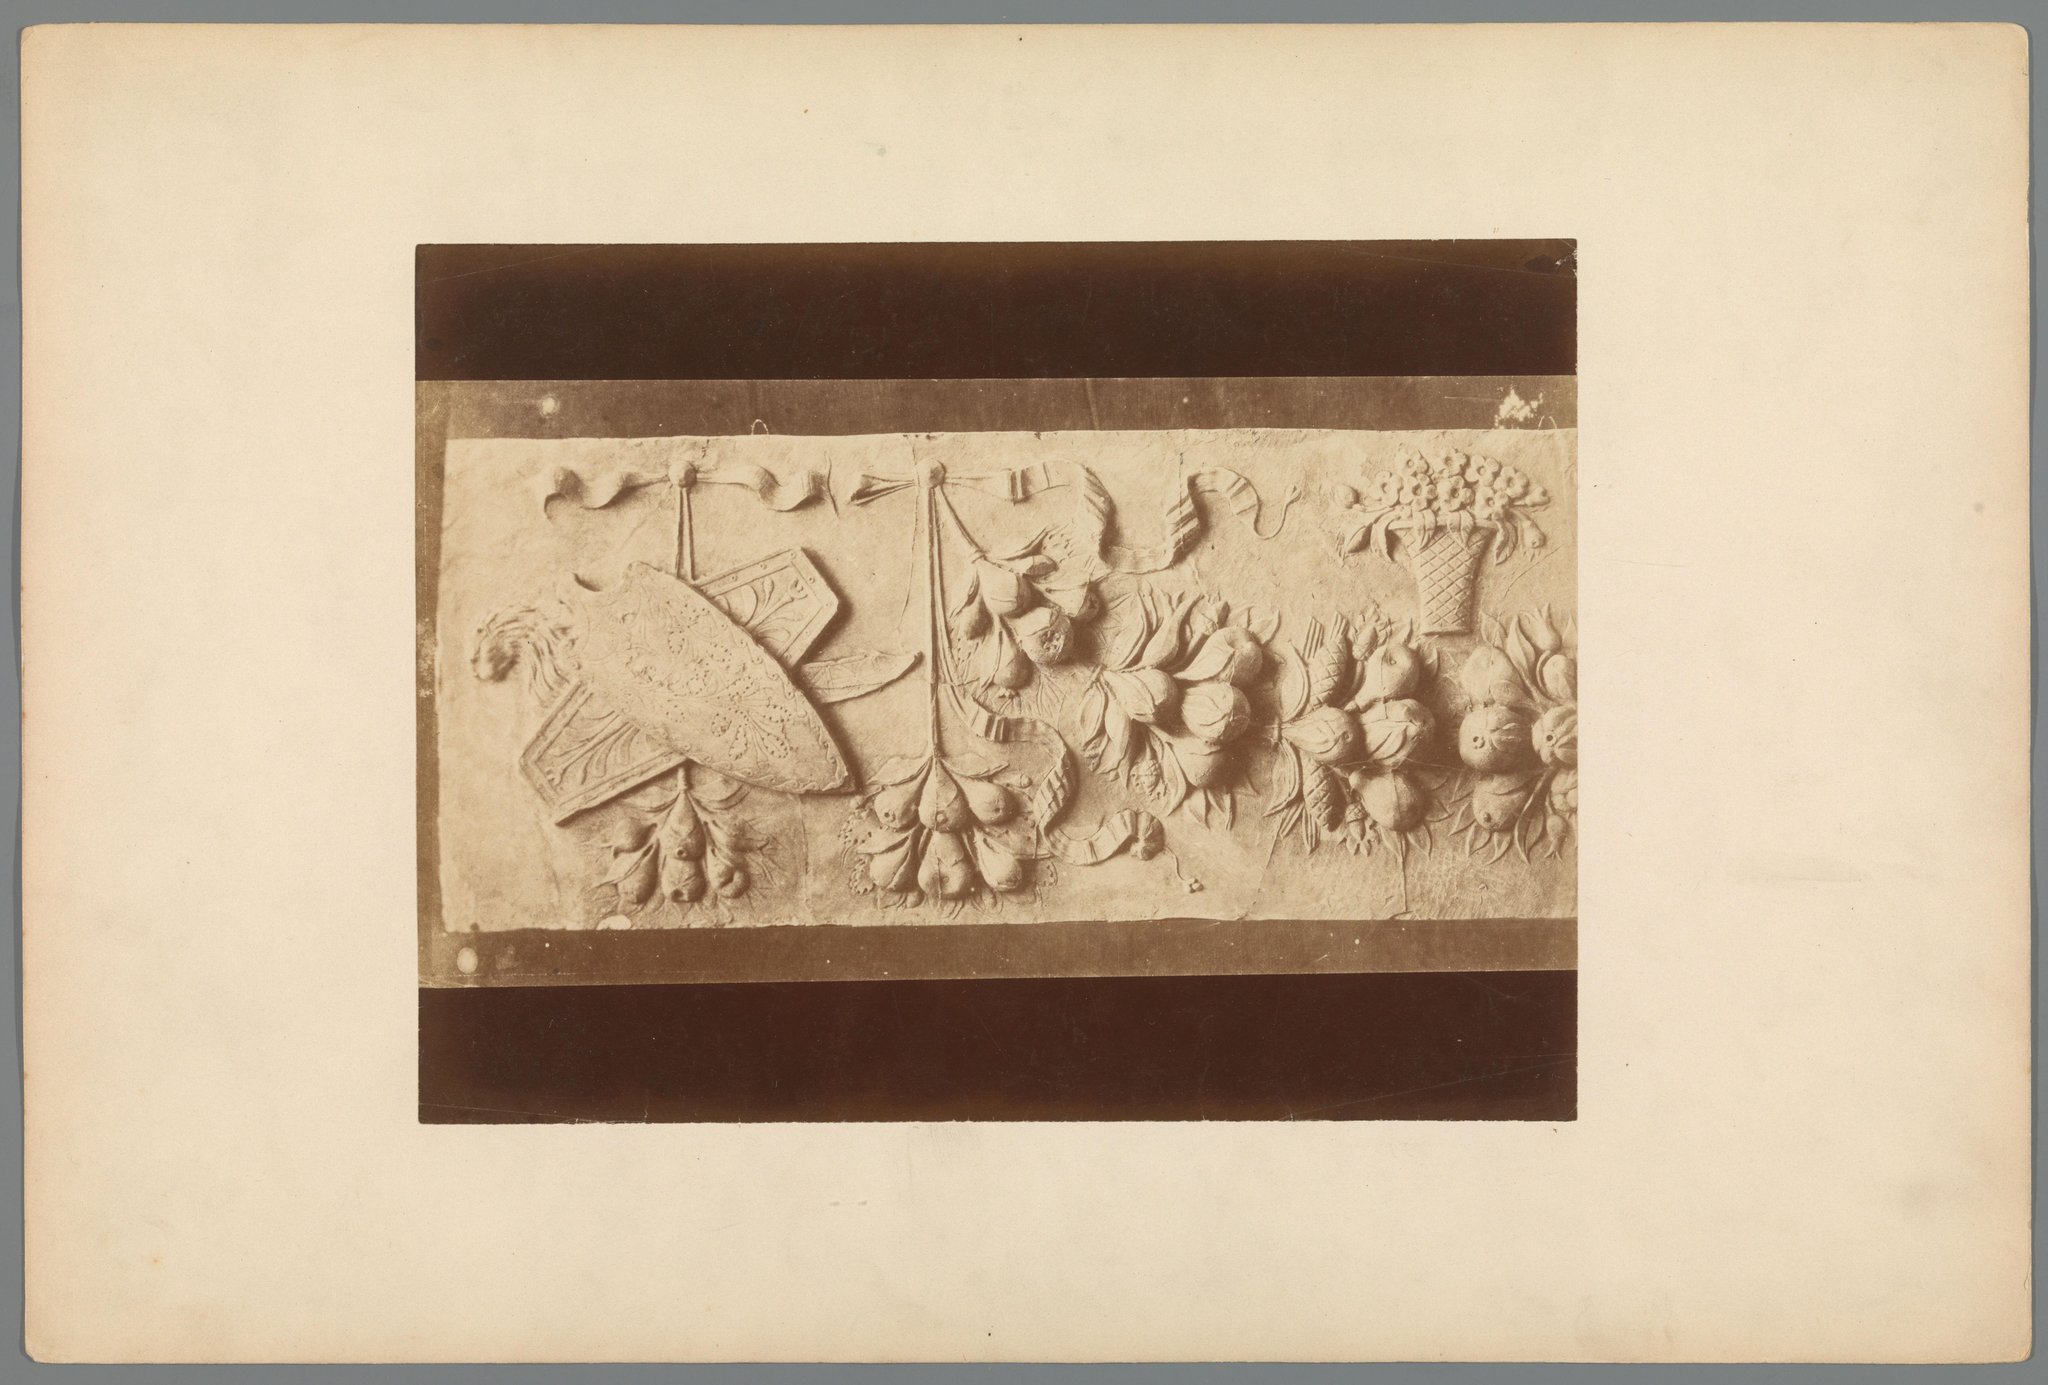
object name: photograph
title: Reliëf met guirlandes, schilden en een leeuwenkop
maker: Anonymous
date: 1875-1900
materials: cardboard, photographic support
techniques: albumen print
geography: europe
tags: protective weapons: shield, lion's head ~ ornament, garland, wreath, sculpture (+ relief ~ sculpture), europe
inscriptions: collector's mark: Lugt 3937